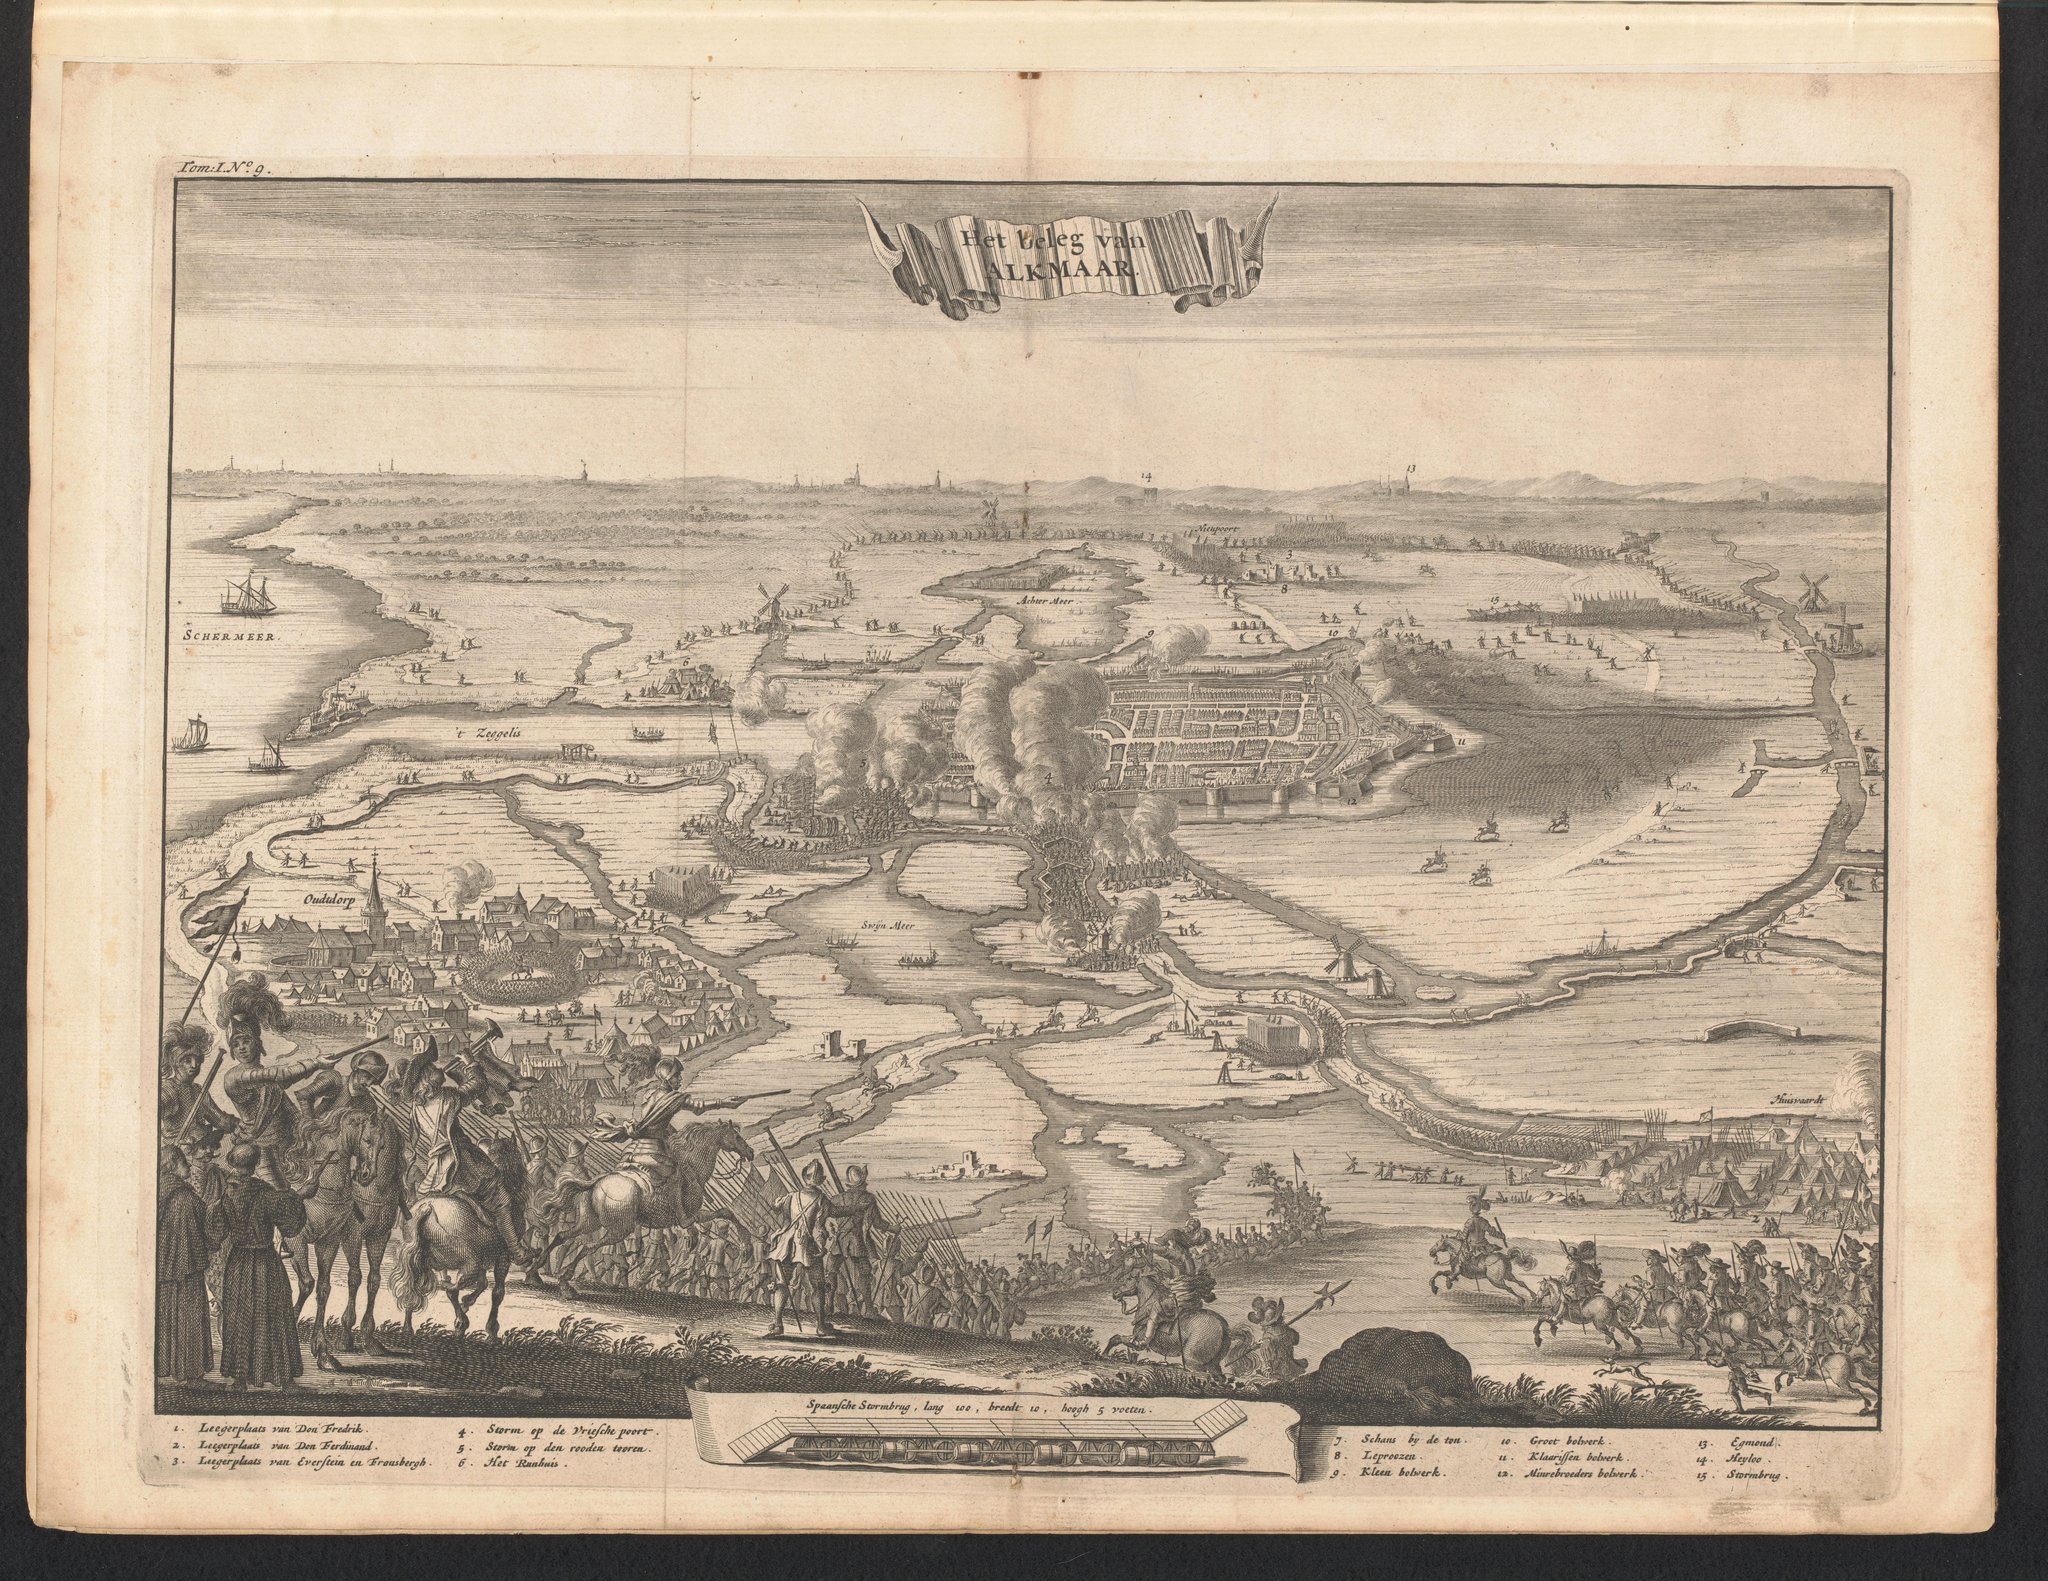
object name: print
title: Het beleg van Alkmaar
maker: coenraet decker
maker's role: print maker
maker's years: 1650-1685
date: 1730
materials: paper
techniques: etching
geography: northern netherlands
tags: siege, position war, bombardment ~ siege, siege arms, e.g.: battering ram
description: Prent waarschijnlijk uit: Le Clerc, Jean. Geschiedenissen der Vereenigde Nederlanden, sedert den aanvang van die Republyk tot op den Vrede van Utrecht in 't jaar 1713 en het Tractaat van Barriere in 't jaar 1715 gesloten. Amsterdam: Zacharias Chatelain, 1730, dl. 1, p. 50-51.